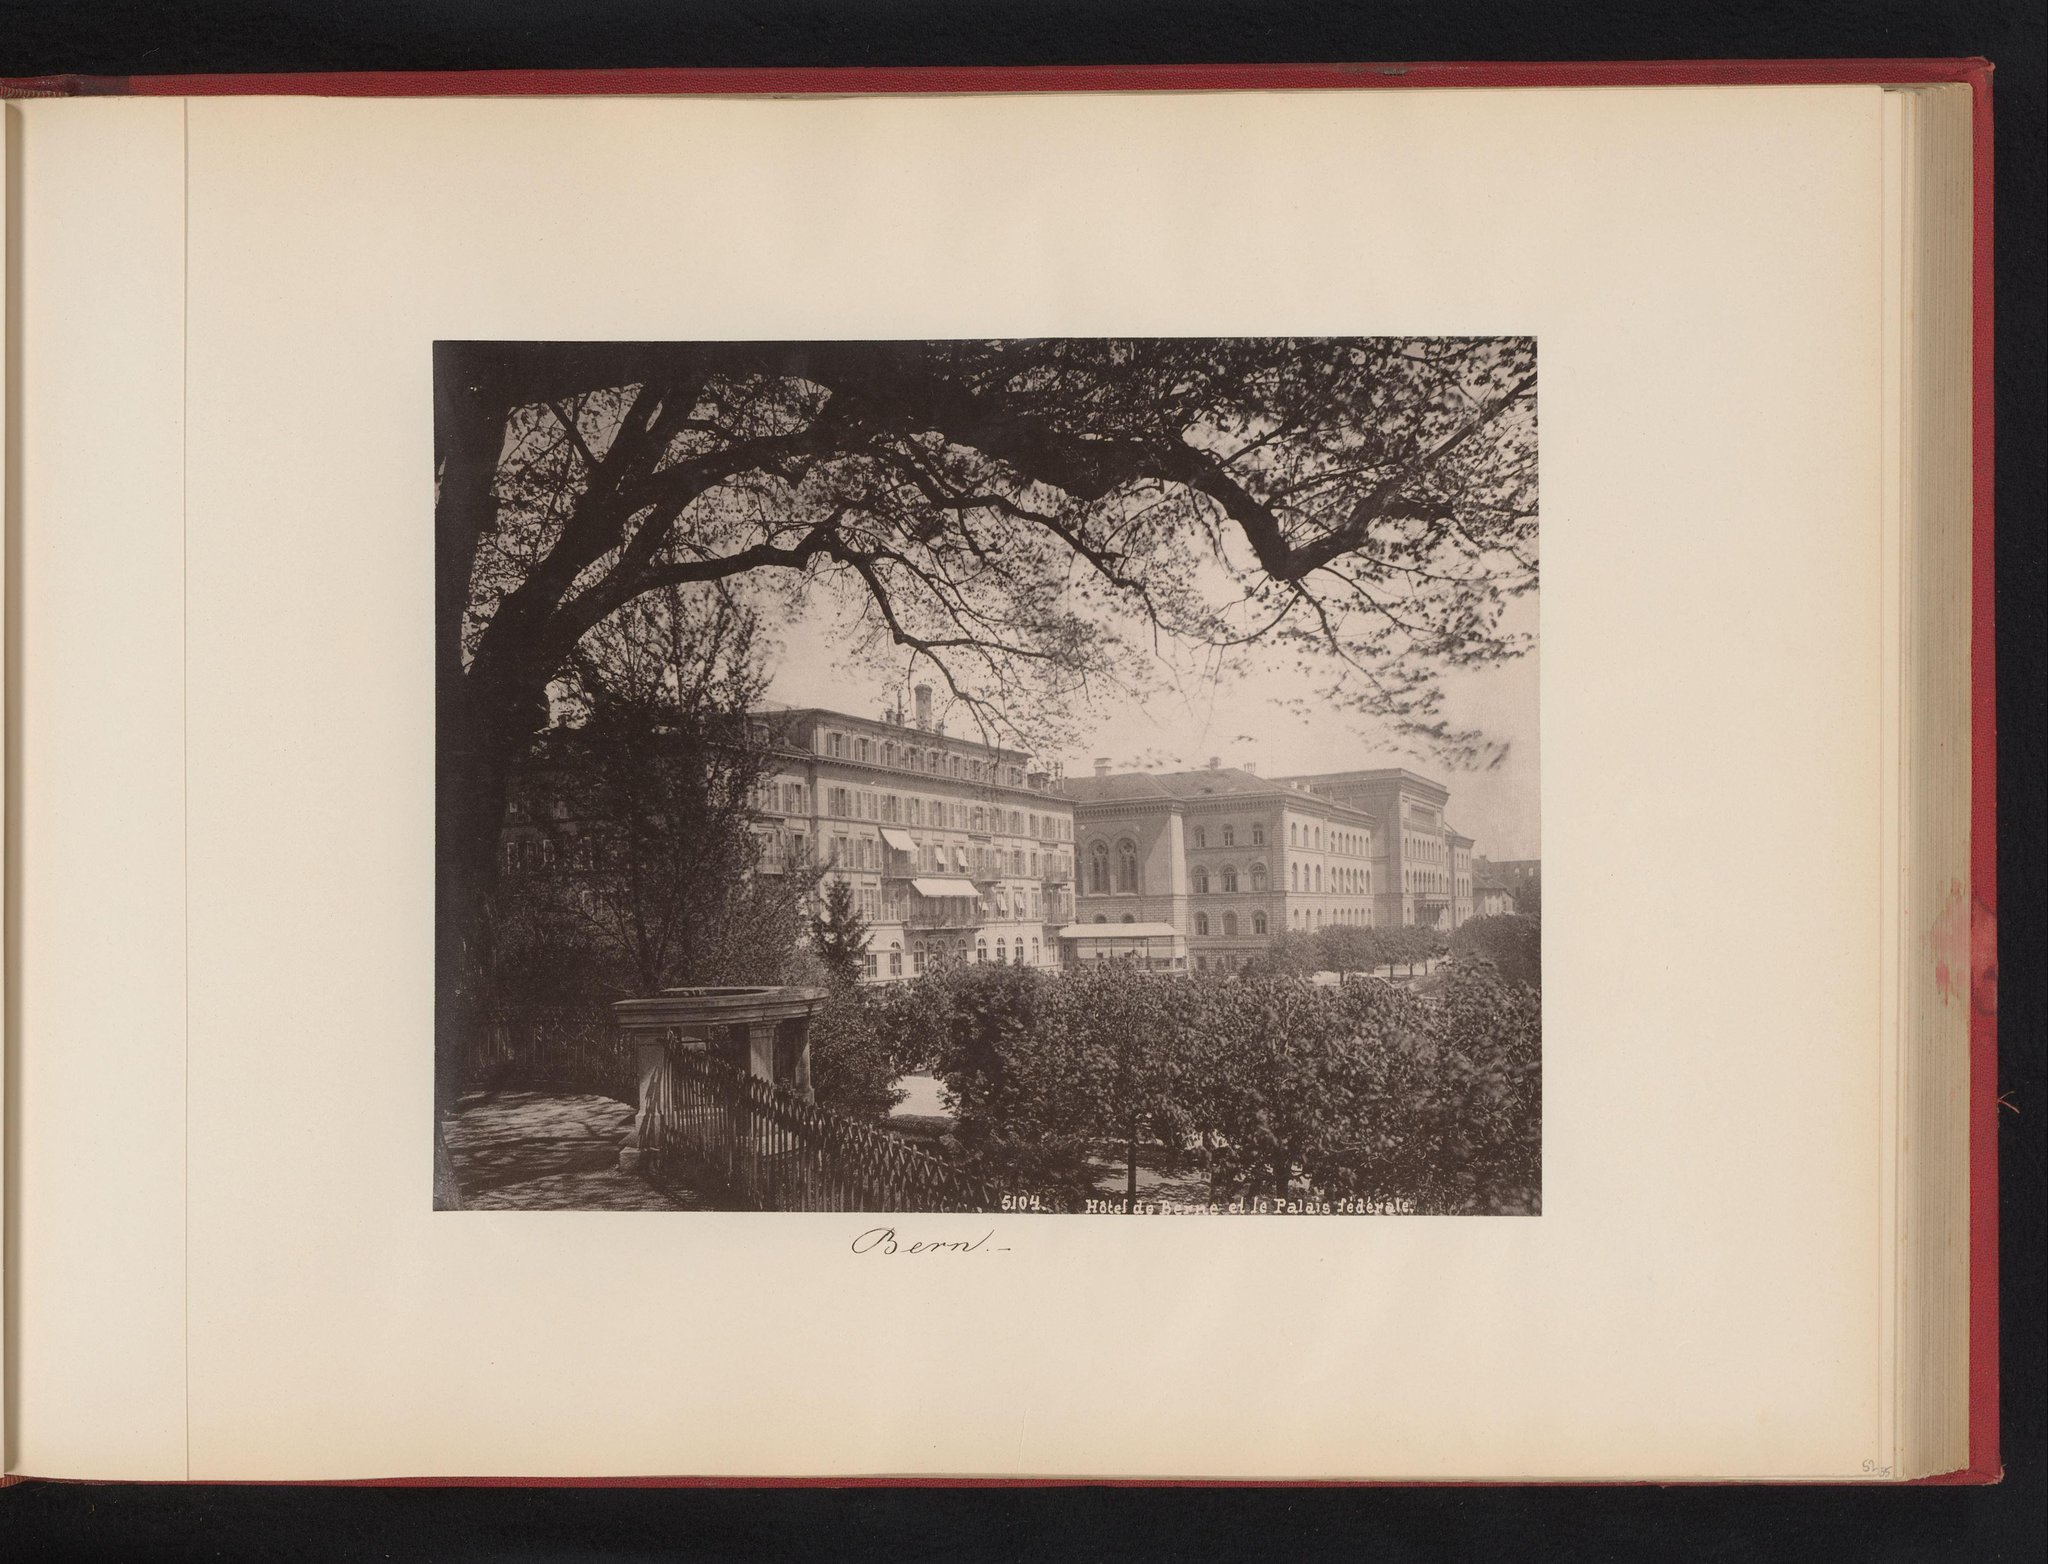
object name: photomechanical print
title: Gezicht op het parlementsgebouw te Bern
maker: Anonymous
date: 1880-1900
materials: paper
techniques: photograph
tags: governmental and representative bodies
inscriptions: inscription: ‘5104. Hôtel de Berne et le Palais fédérale.’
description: Deze prent maakt deel uit van een album.